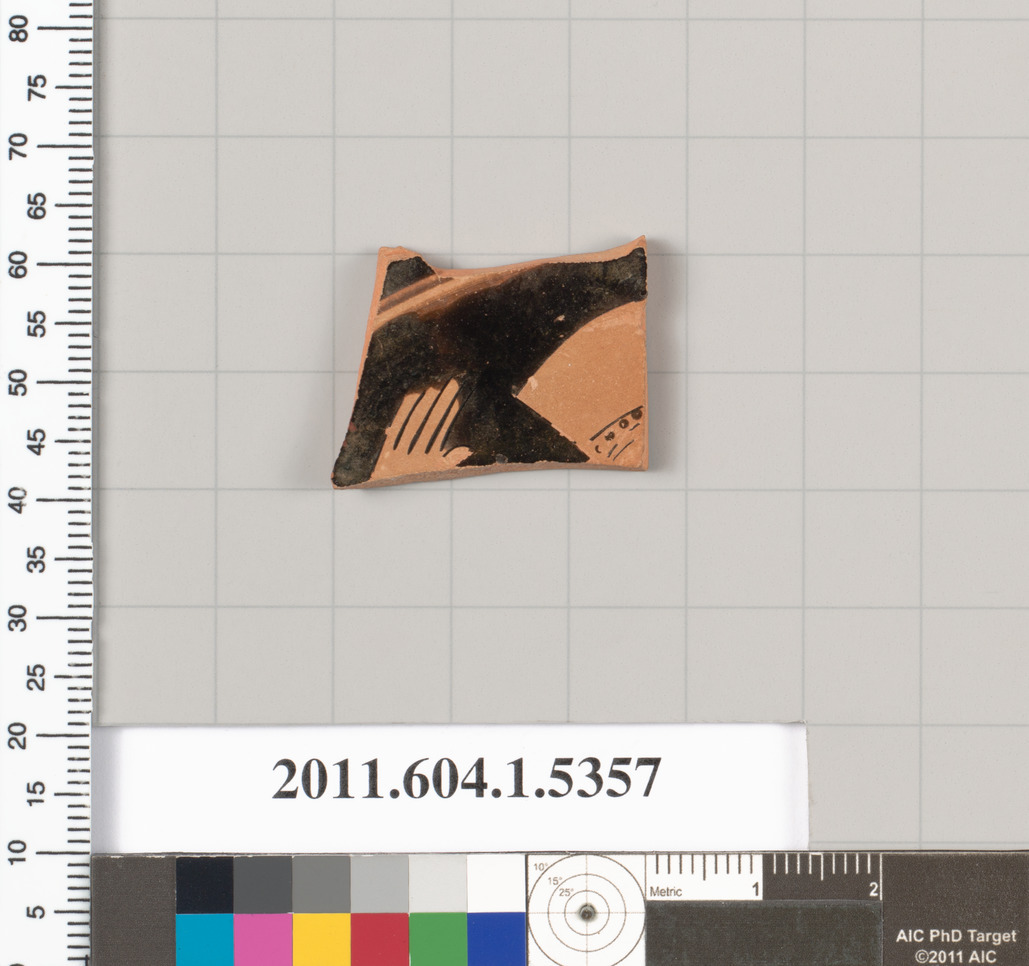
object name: kylix fragment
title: Terracotta fragment of a kylix (drinking cup)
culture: greek, attic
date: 520-500 BCE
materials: terracotta